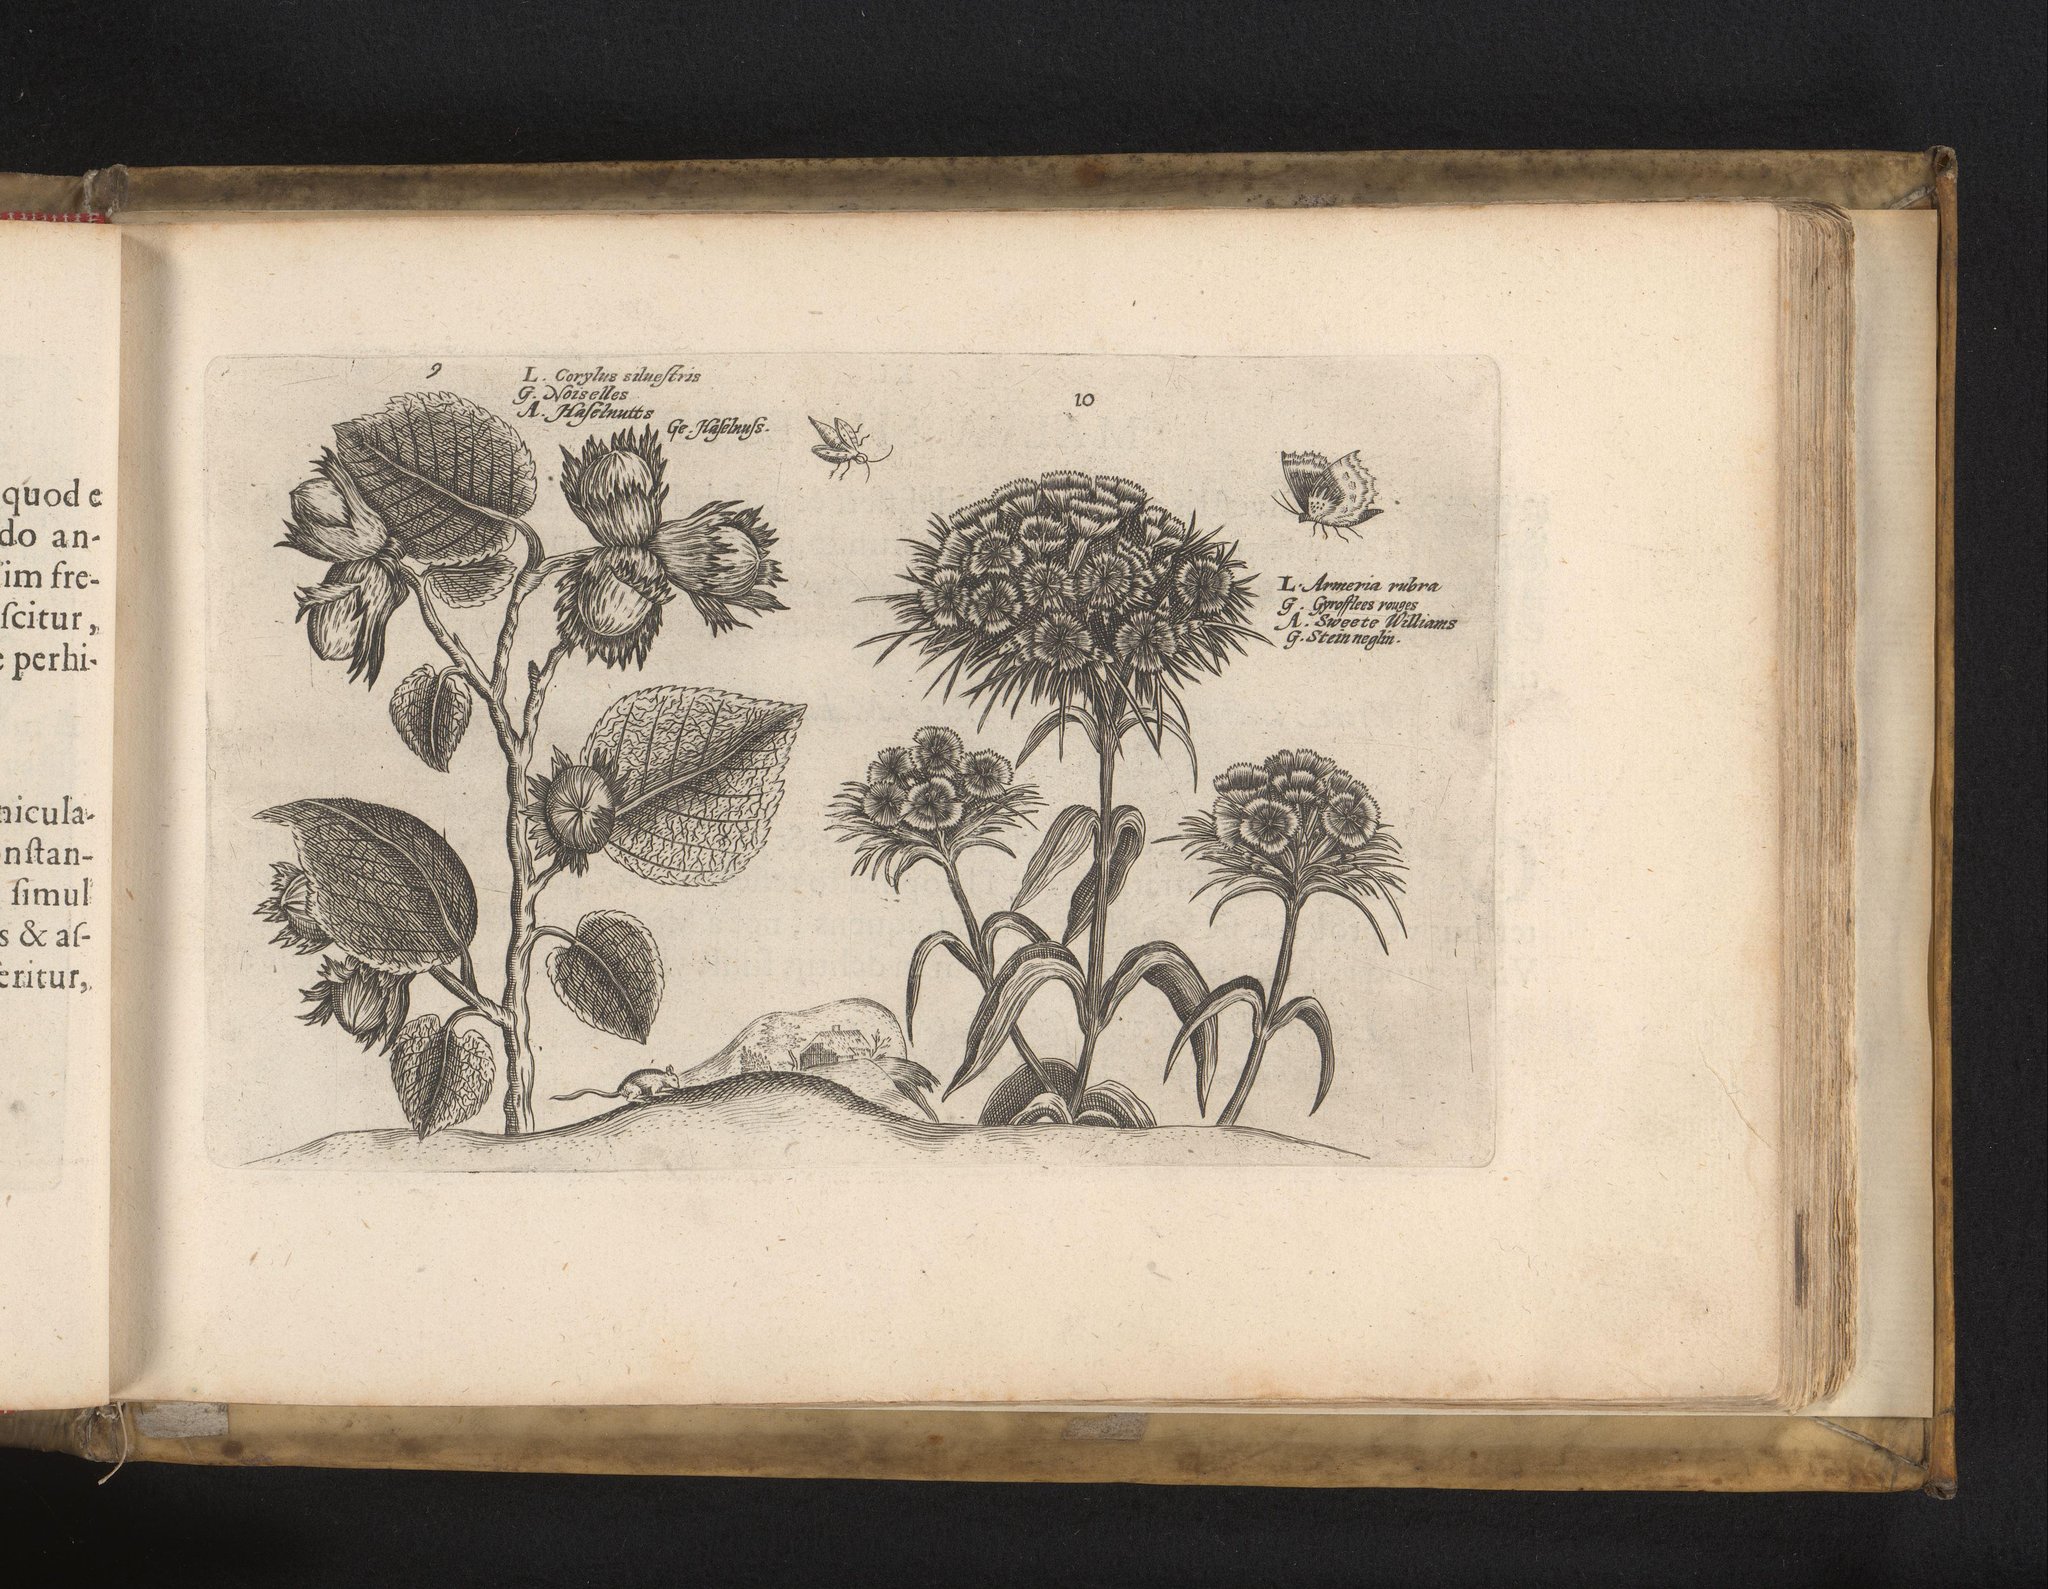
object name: book illustration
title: Bloementuin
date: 1617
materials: paper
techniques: engraving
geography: arnhem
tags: flowers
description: Prent uit: Passe, Crispijn van de (II). Hortus floridus in quo rariorum & minus vulgarium florum icones ad vivam veramque formam. Arnhem: Johannes Janssonius, 1617.